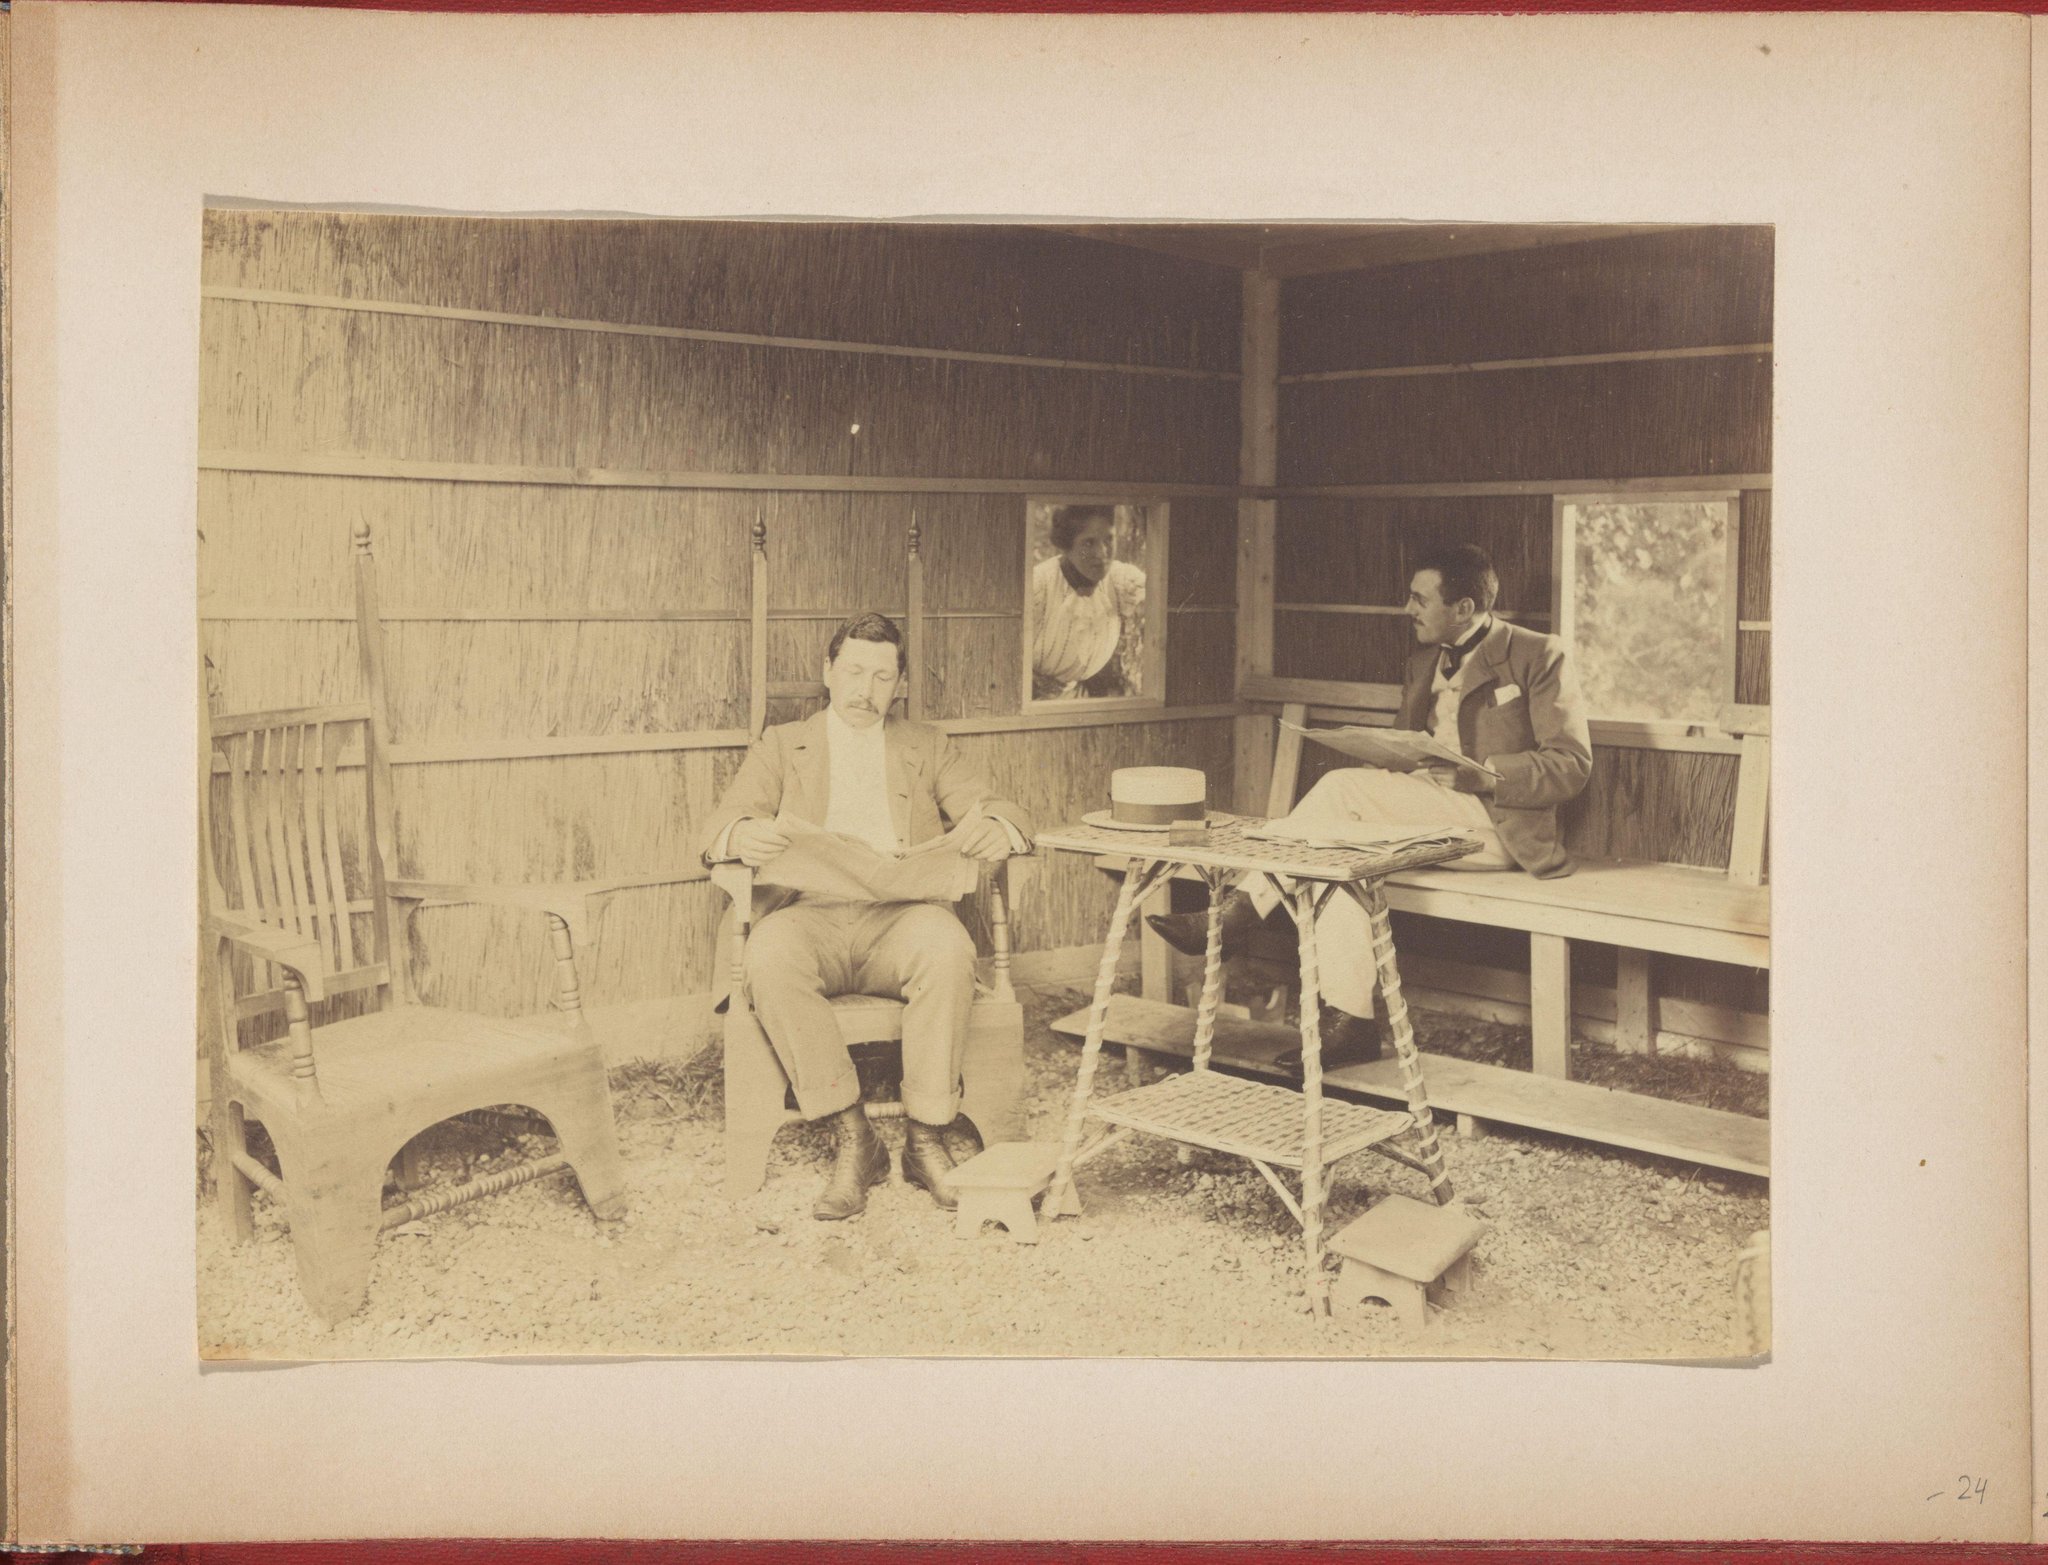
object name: photograph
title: Gerard Aalbersberg en Jan Kleintjes lezen onder een veranda, Hedwig Kleintjes kijkt door het raam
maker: gerard aalbersberg (us)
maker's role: amateurfotograaf, arts, chirurg, gynaecoloog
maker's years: 1870-1934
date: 1900-1906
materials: paper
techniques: gelatin silver print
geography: heerde